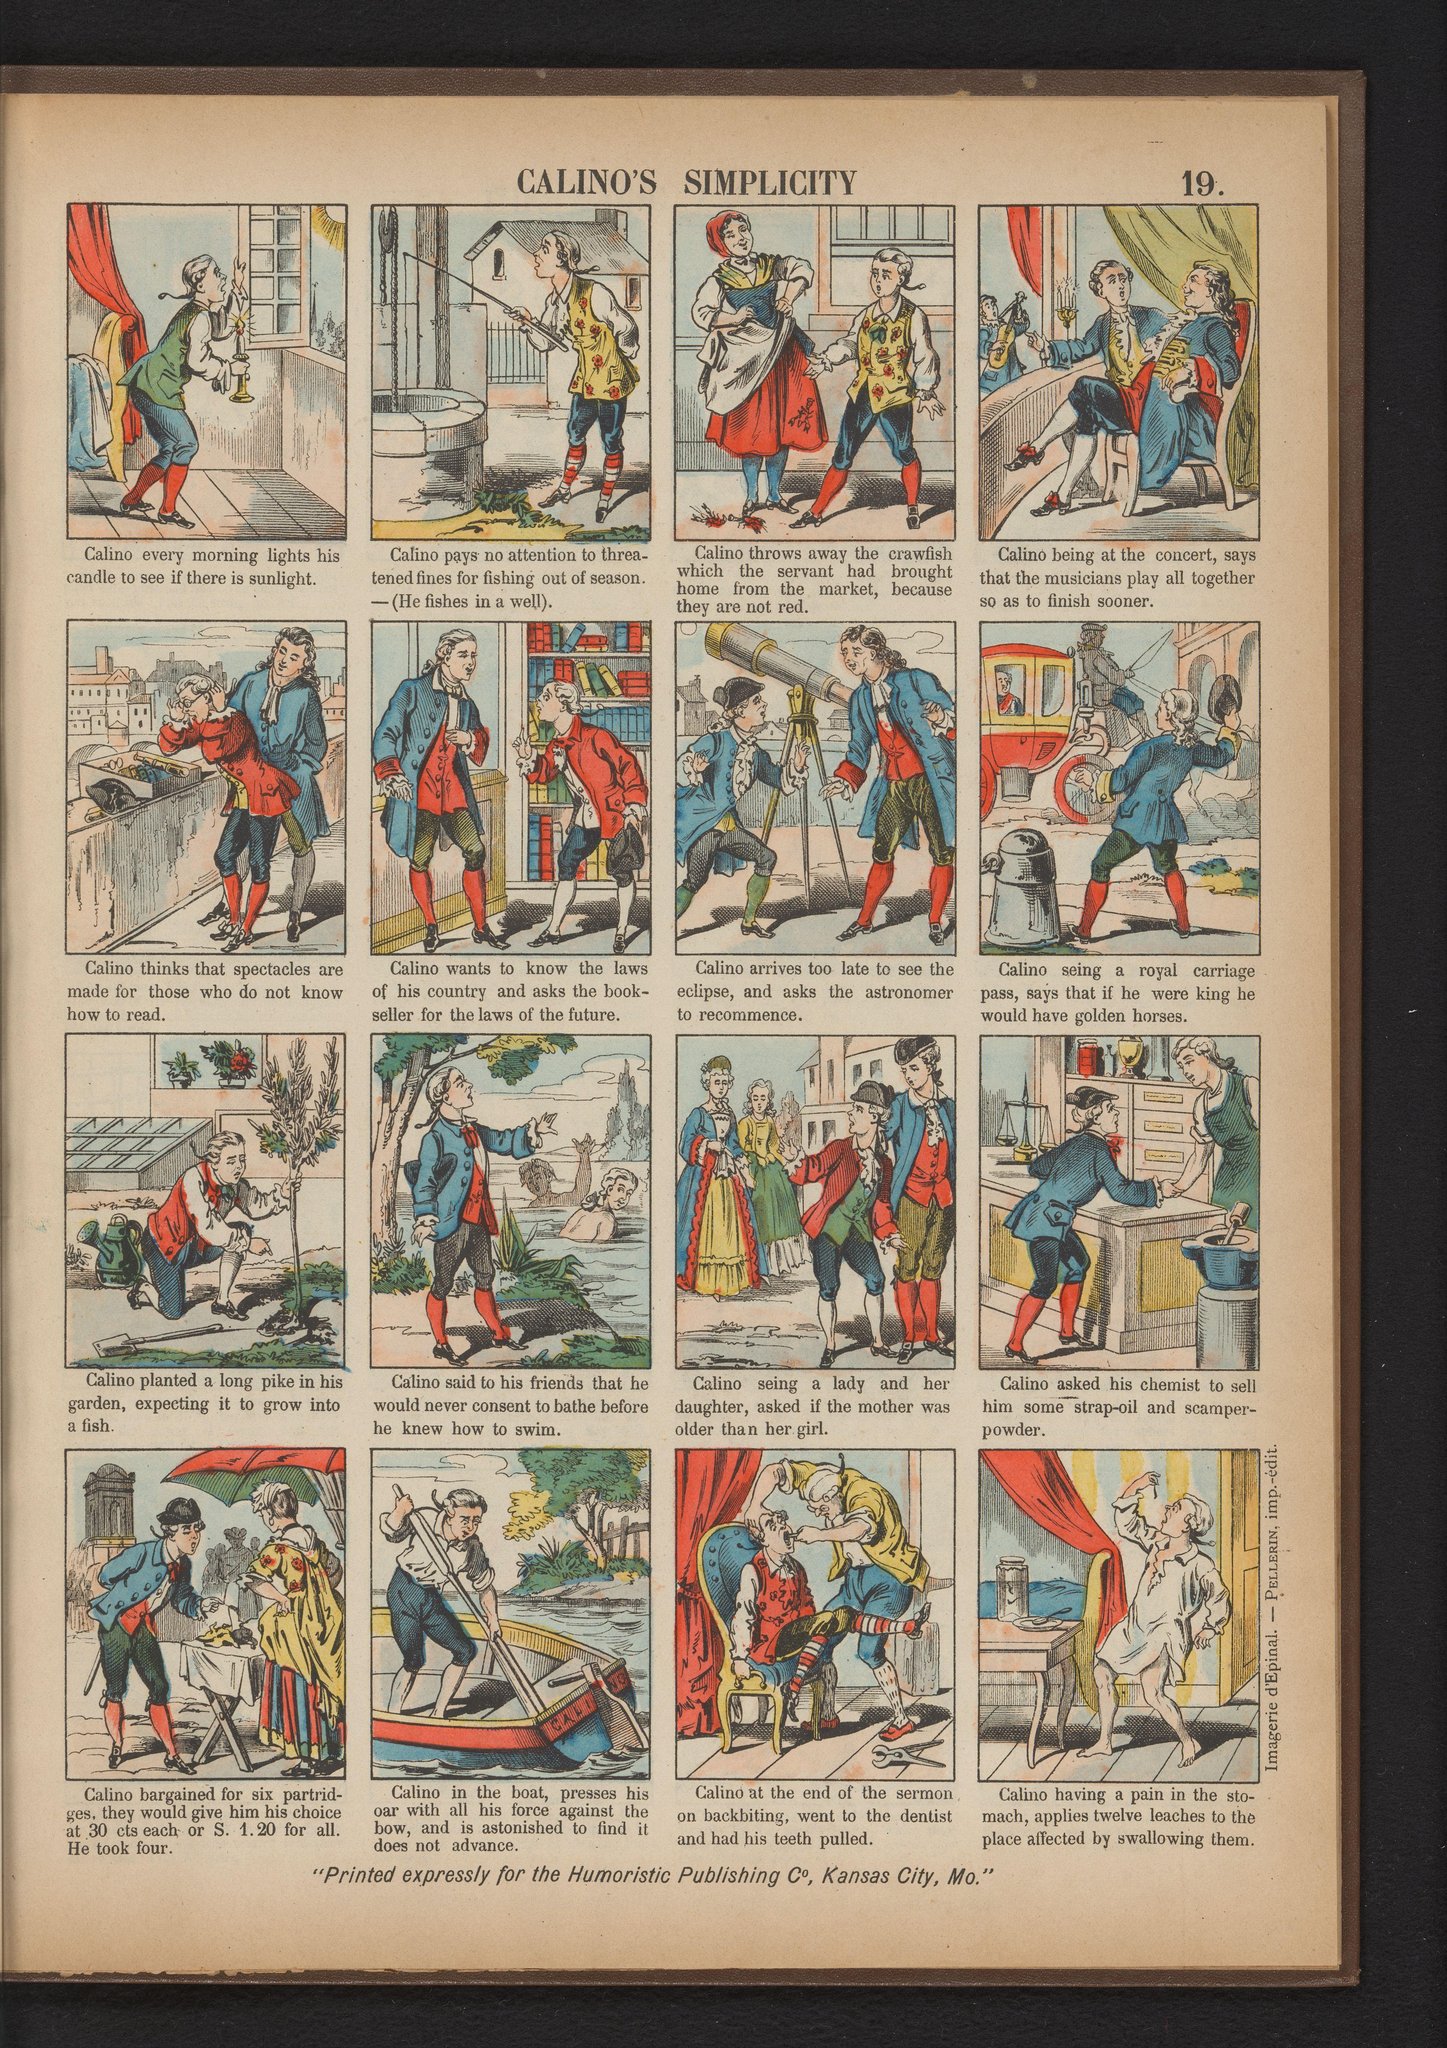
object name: popular print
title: Contes des fées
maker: Anonymous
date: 1893-1894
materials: paper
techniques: colour, letterpress printing, lithograph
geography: epinal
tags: fool, simpleton, numskull, stupidity, poverty of intellect; 'stupidità overo stolidità' (ripa)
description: Blad met zestien voorstellingen over de stommiteiten van Calino. Onder elke voorstelling een onderschrift in het Engels. Deze prent maakt deel uit van een album.